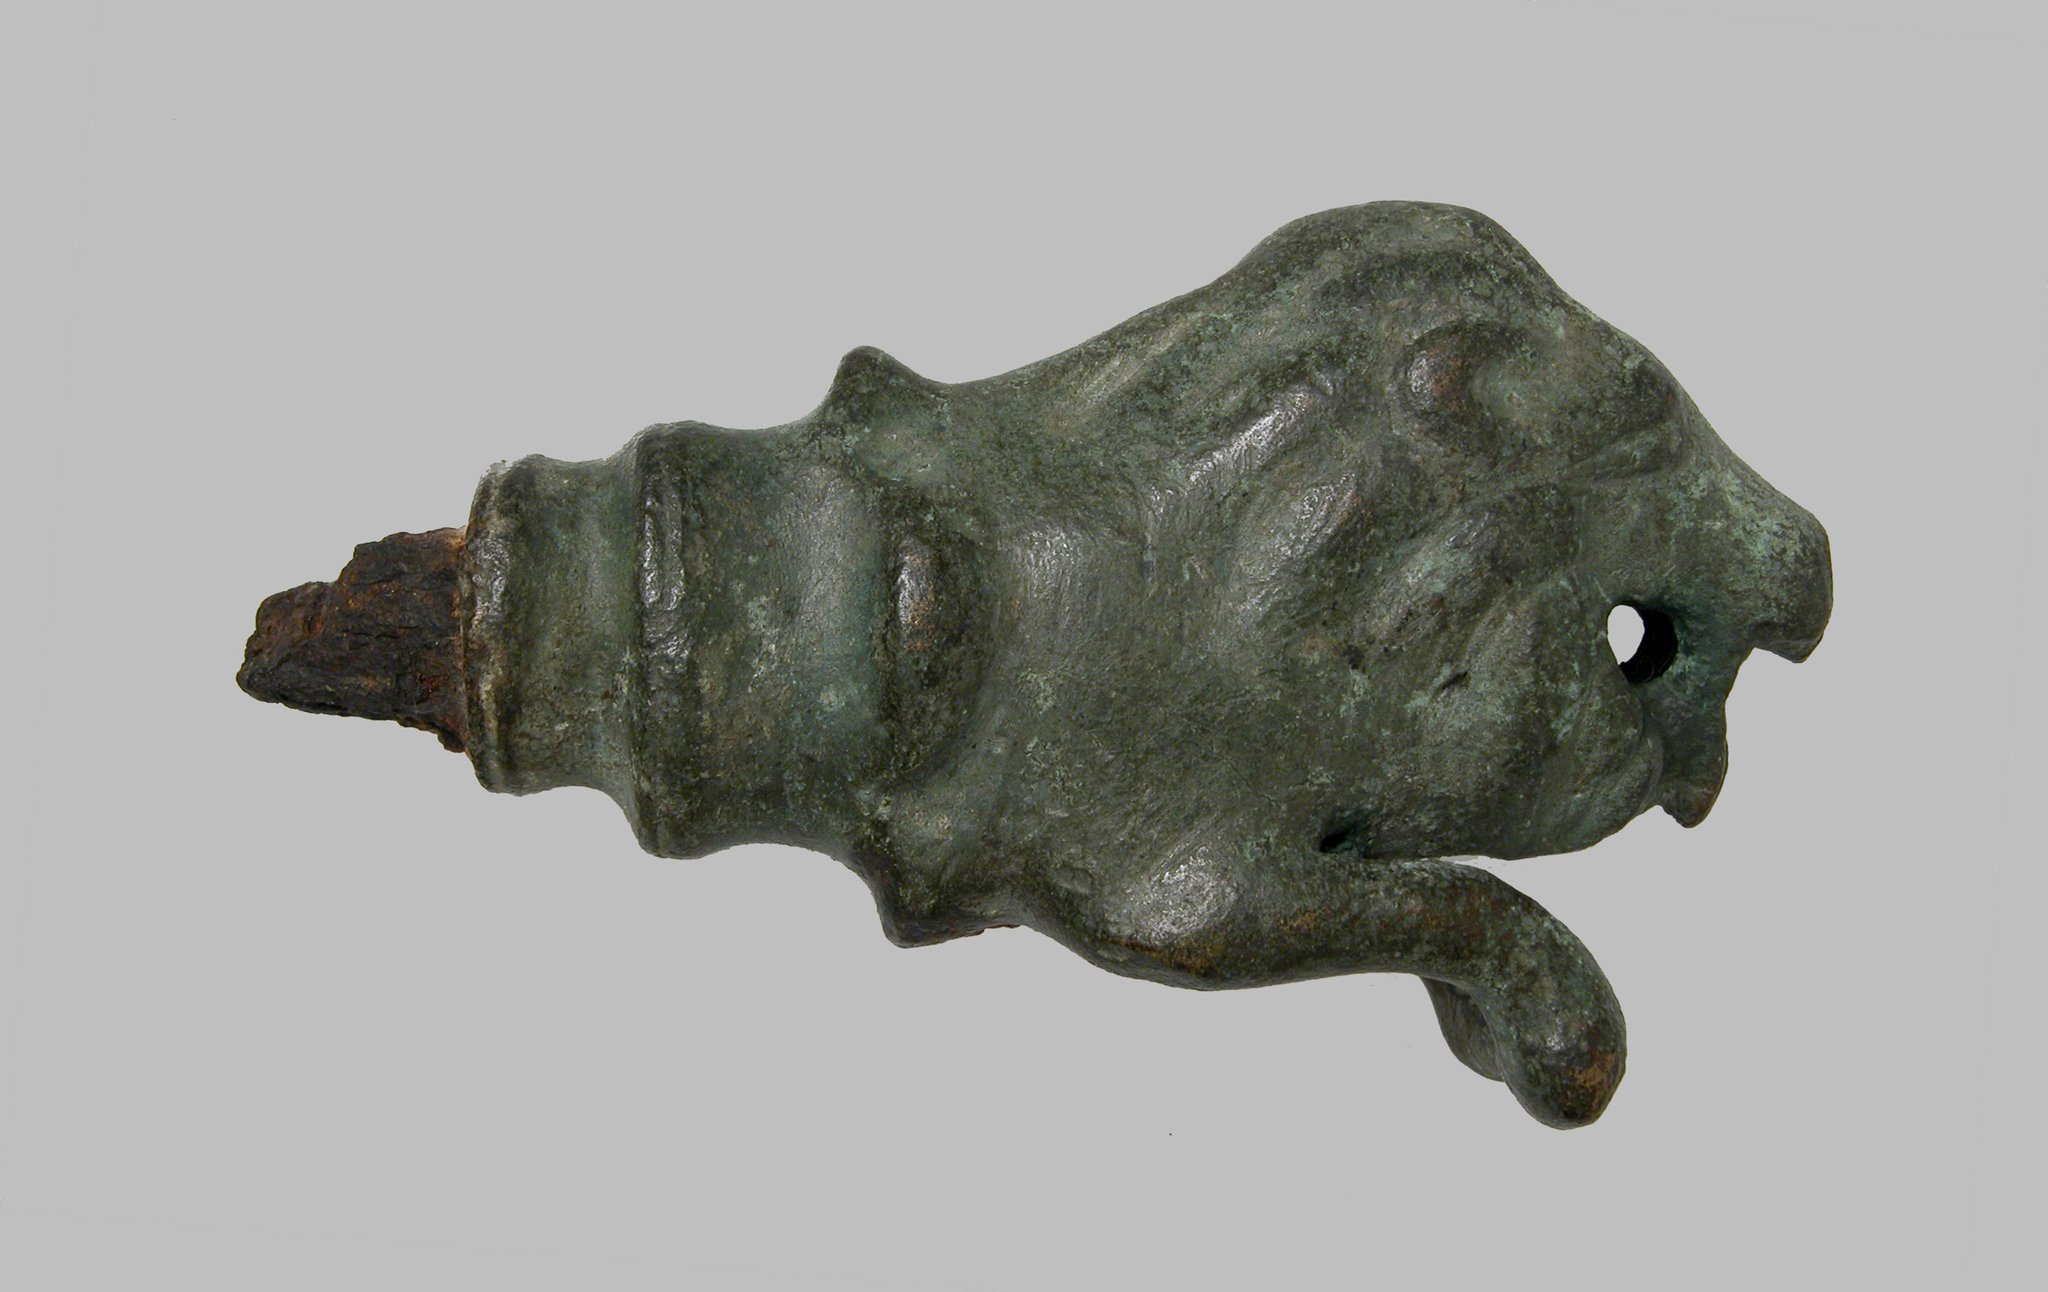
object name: key handle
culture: roman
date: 1-700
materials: copper alloy, iron